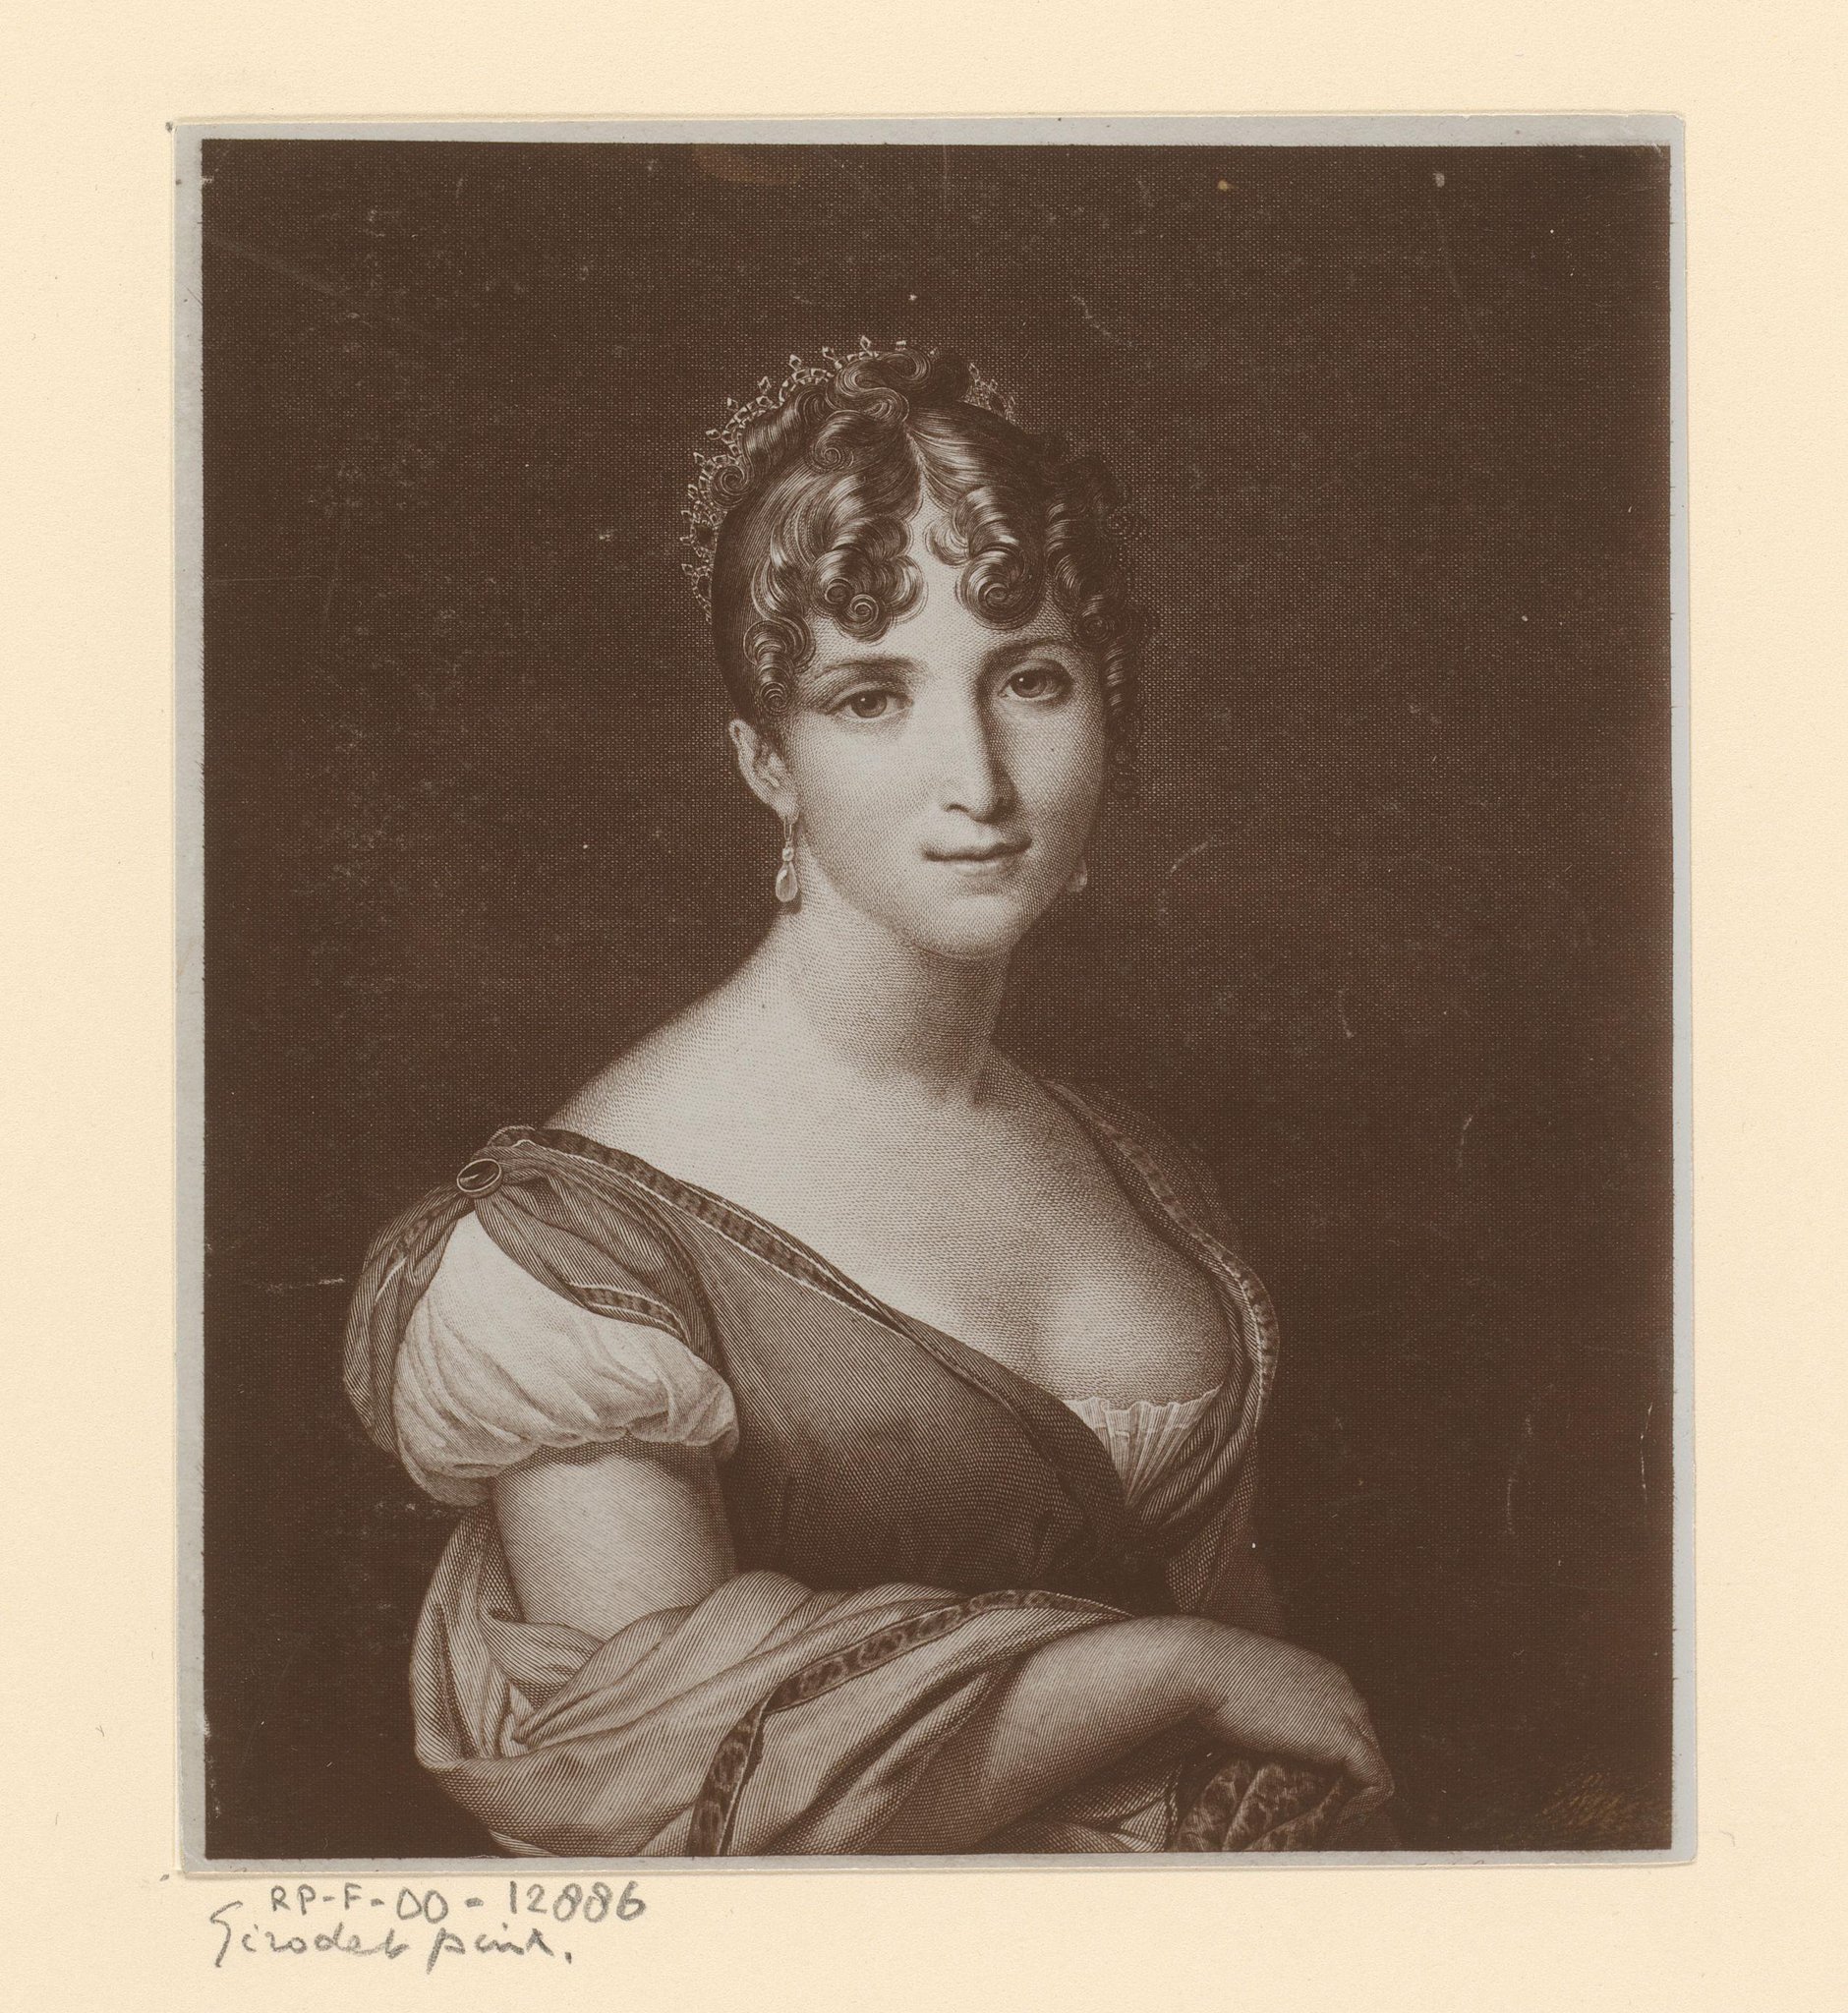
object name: photograph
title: Fotoreproductie van een gegraveerd portret van koningin Hortense de Beauharnais naar een schilderij van Girordet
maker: Anonymous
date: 1903-1910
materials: paper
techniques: collodion silver print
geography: amsterdam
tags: paris, historical persons - bb - woman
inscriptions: inscription: ‘Reine Hortense’